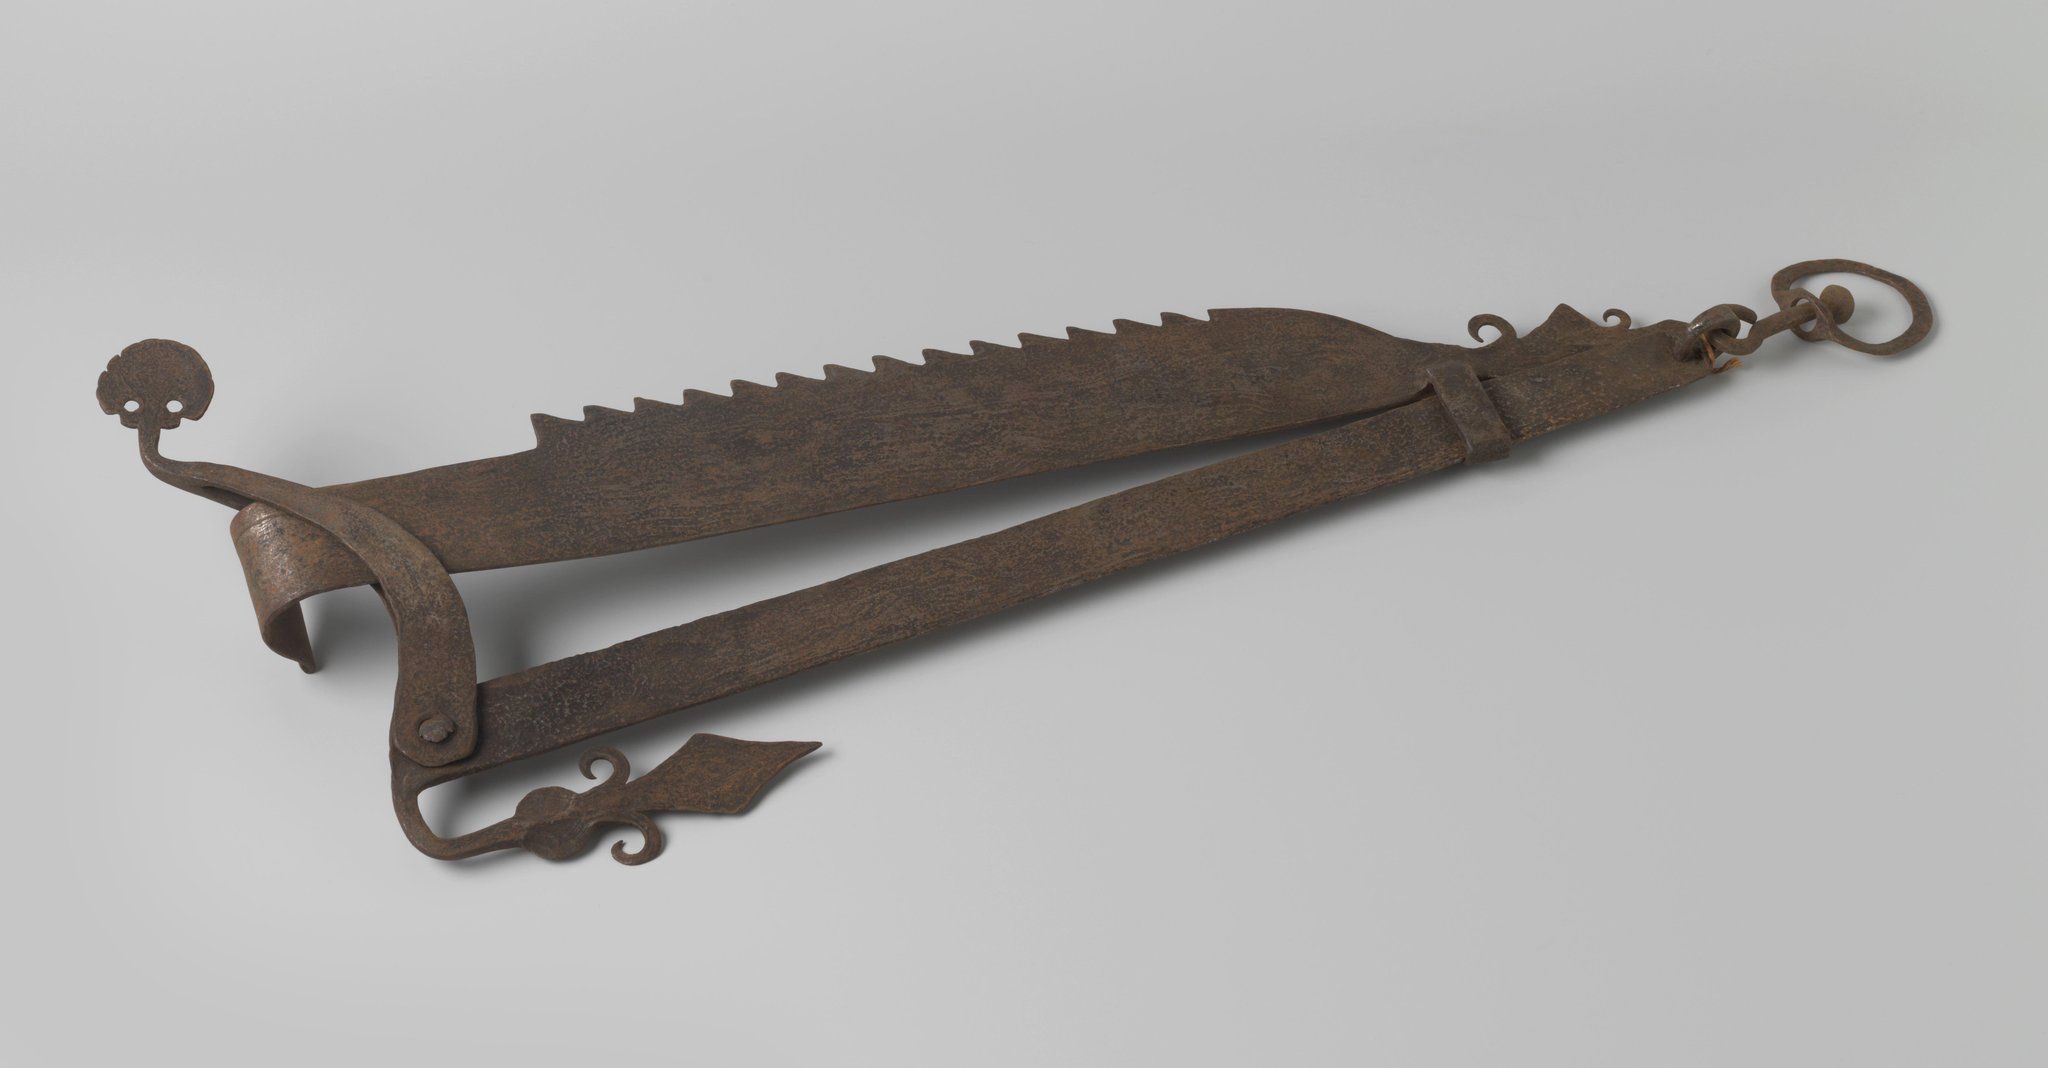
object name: chimney hook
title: Schoorsteenhaak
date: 1400-1950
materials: iron